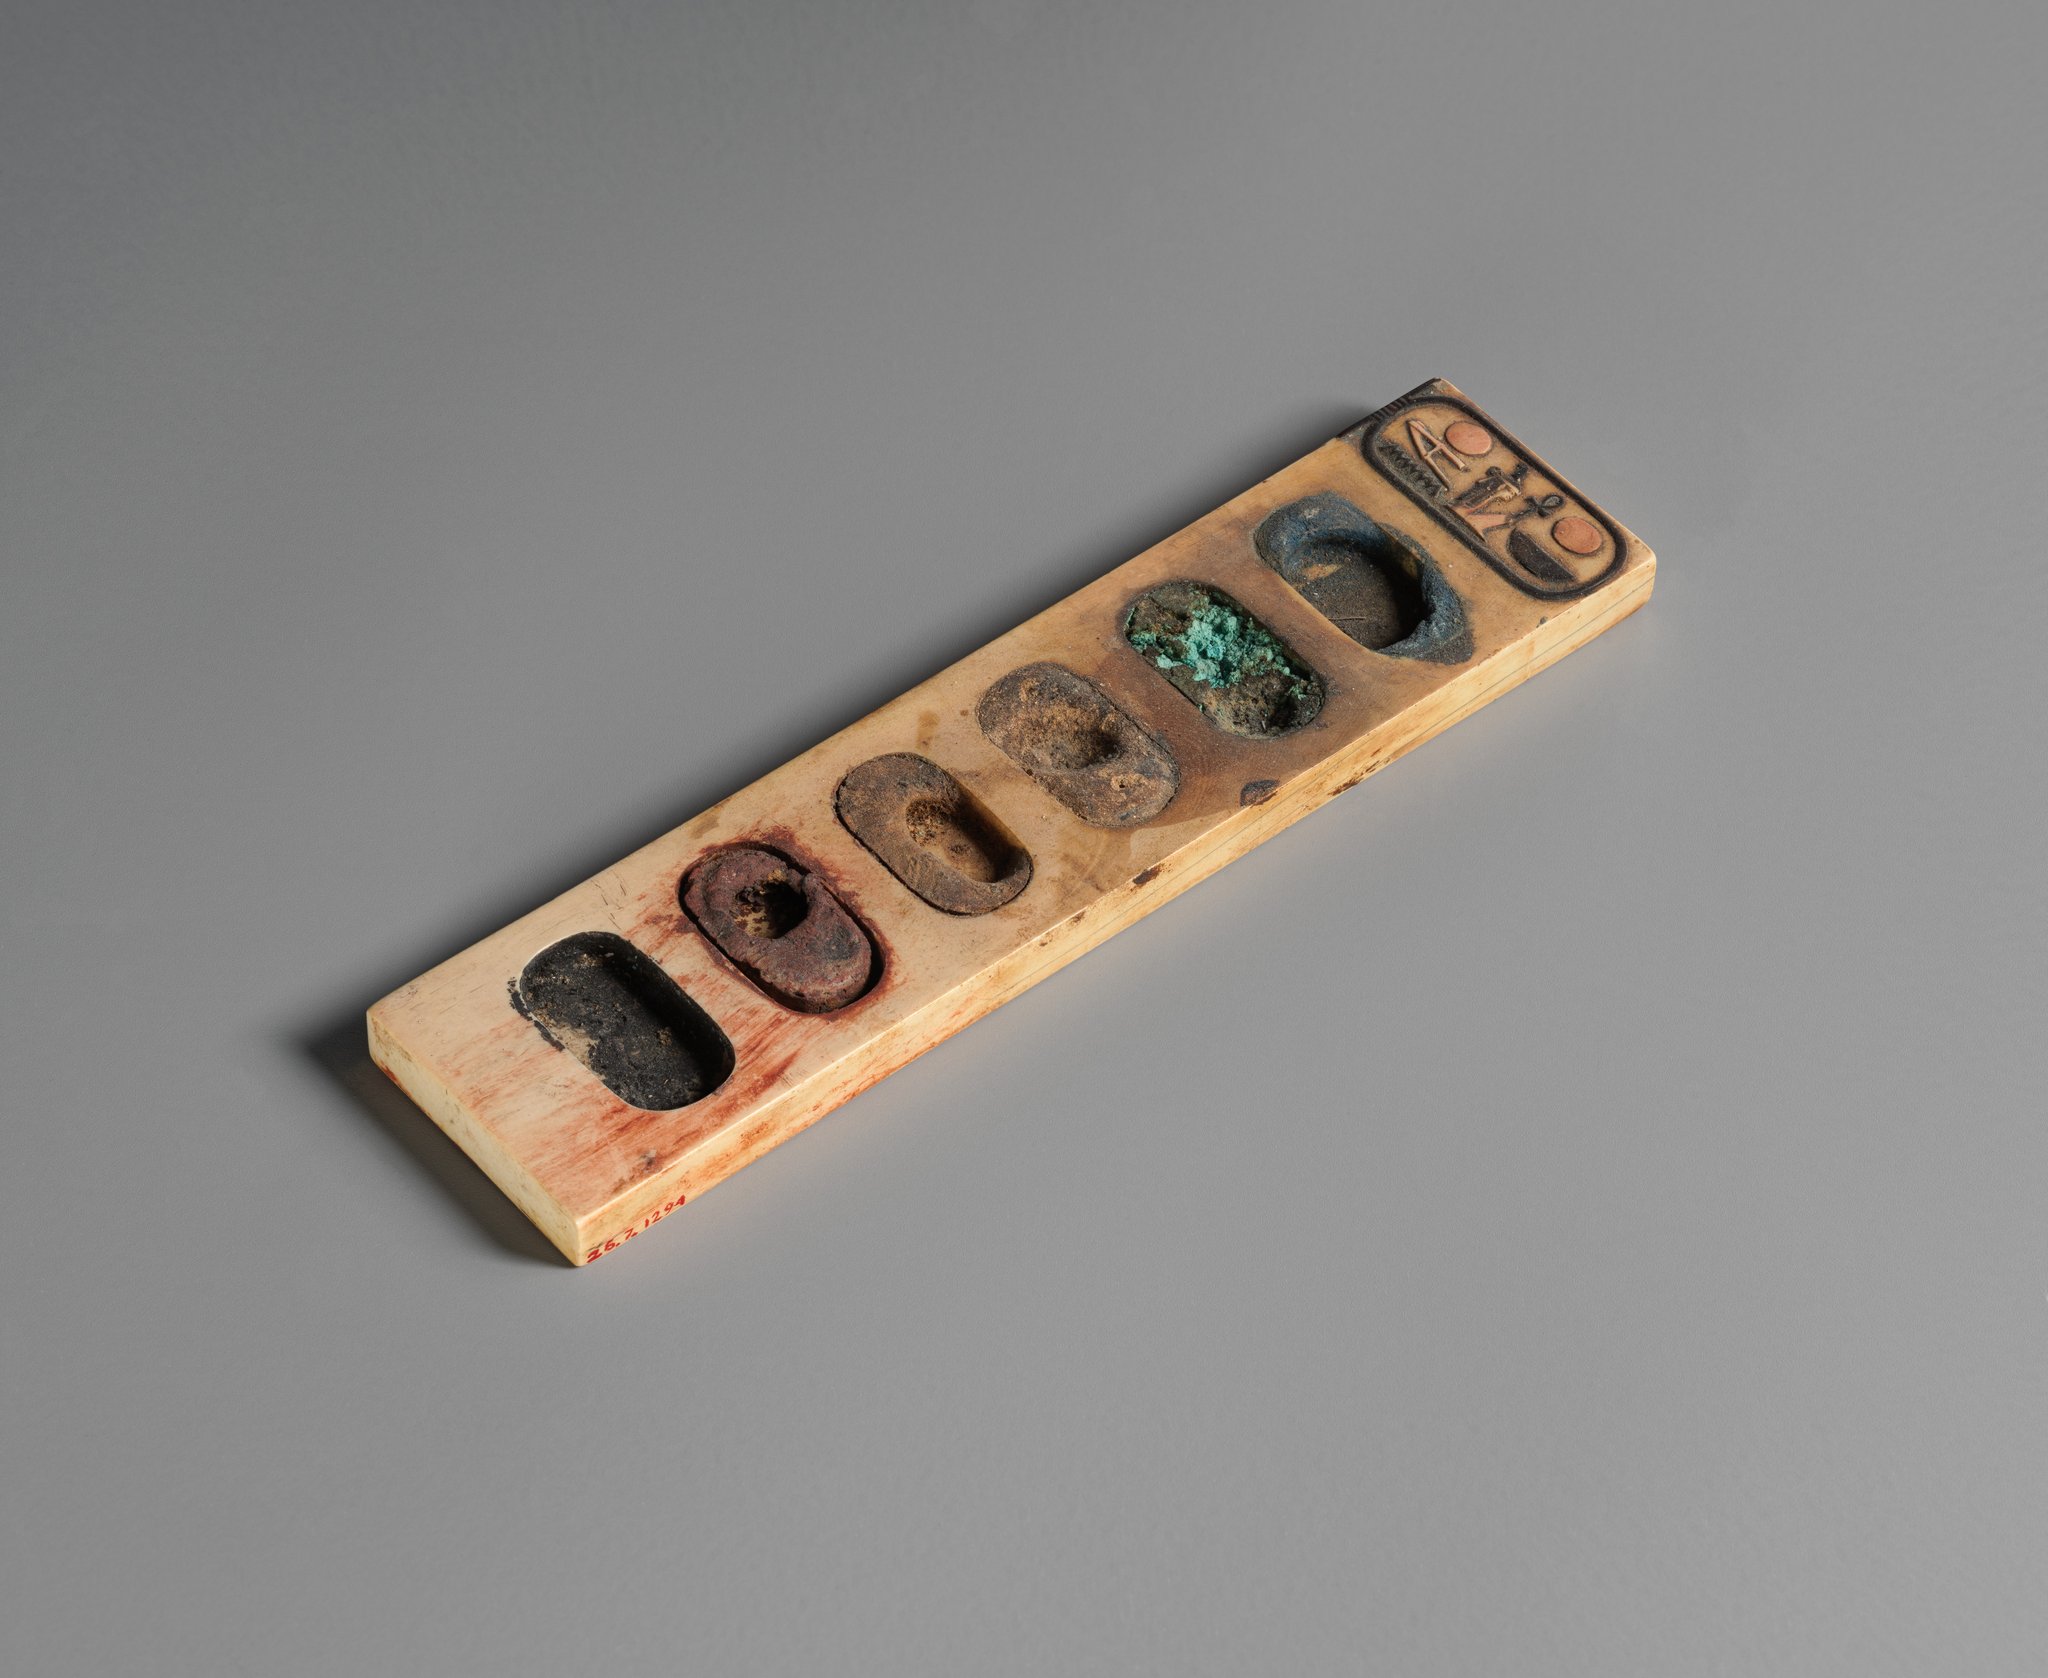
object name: palette, painting, amenhotep iii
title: Painter's Palette Inscribed with the Name of Amenhotep III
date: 1390-1352 BCE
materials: ivory, pigment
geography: upper egypt, thebes